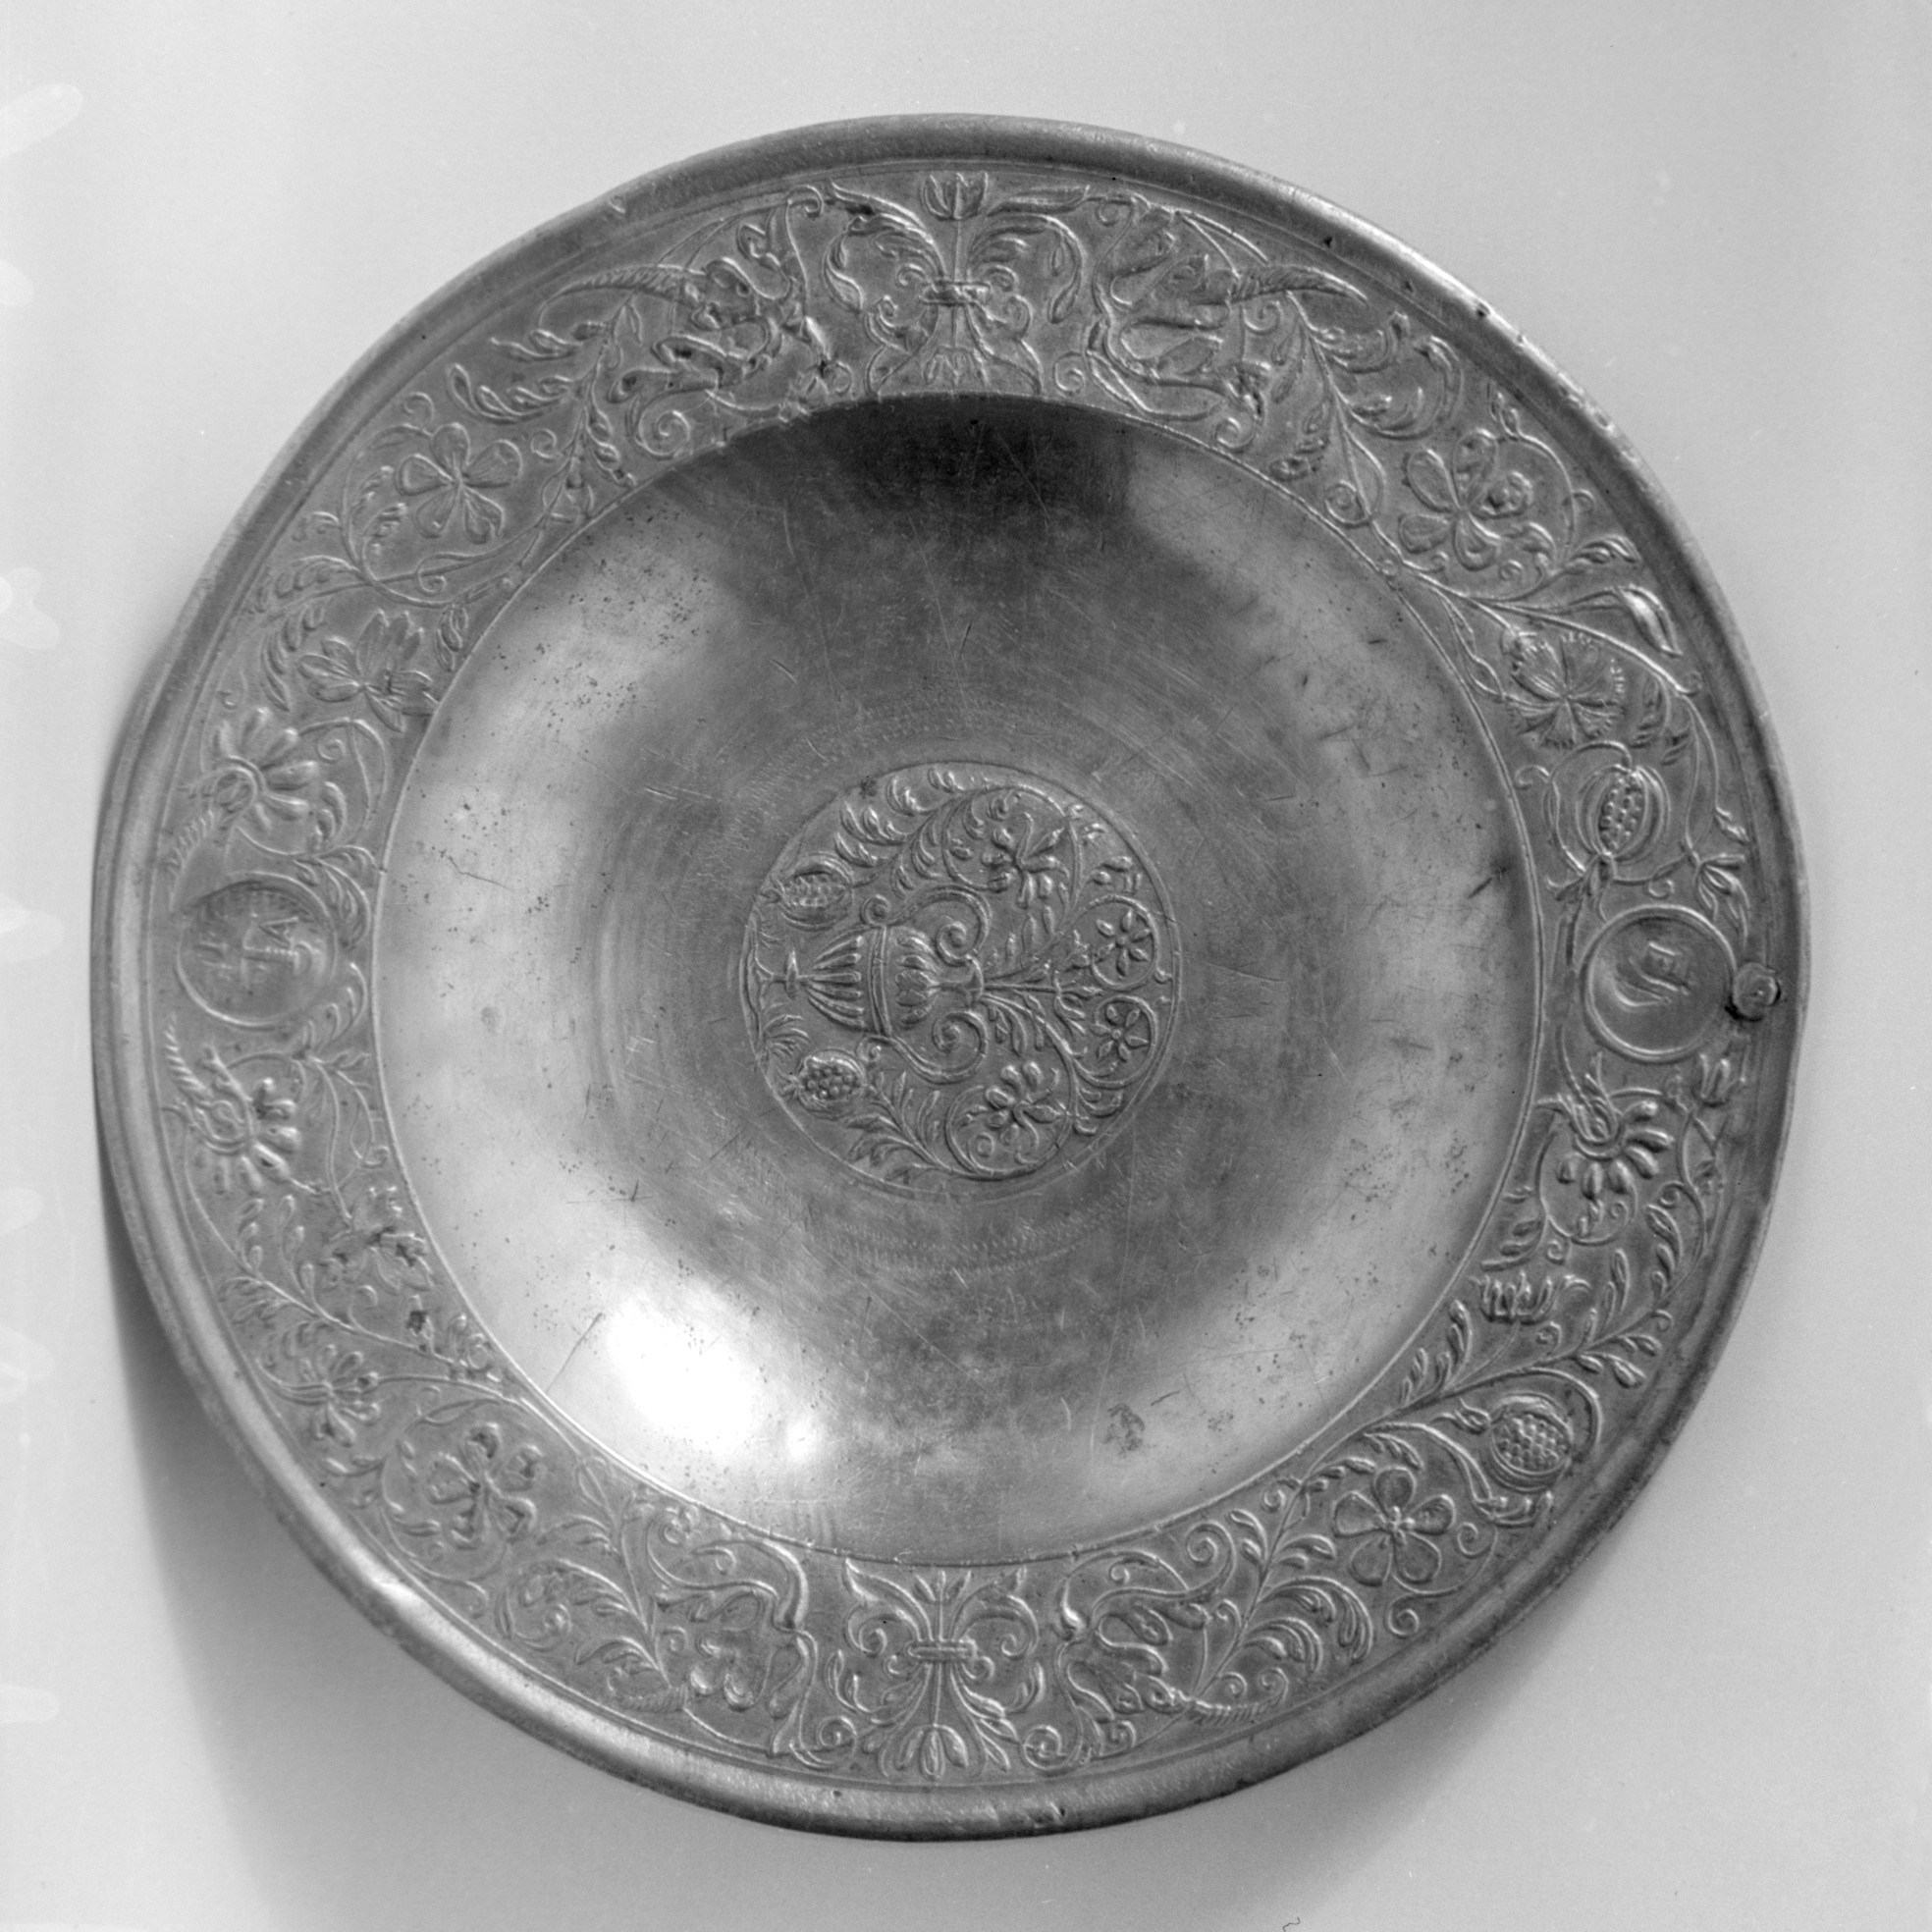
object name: plate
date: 1701-1800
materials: pewter